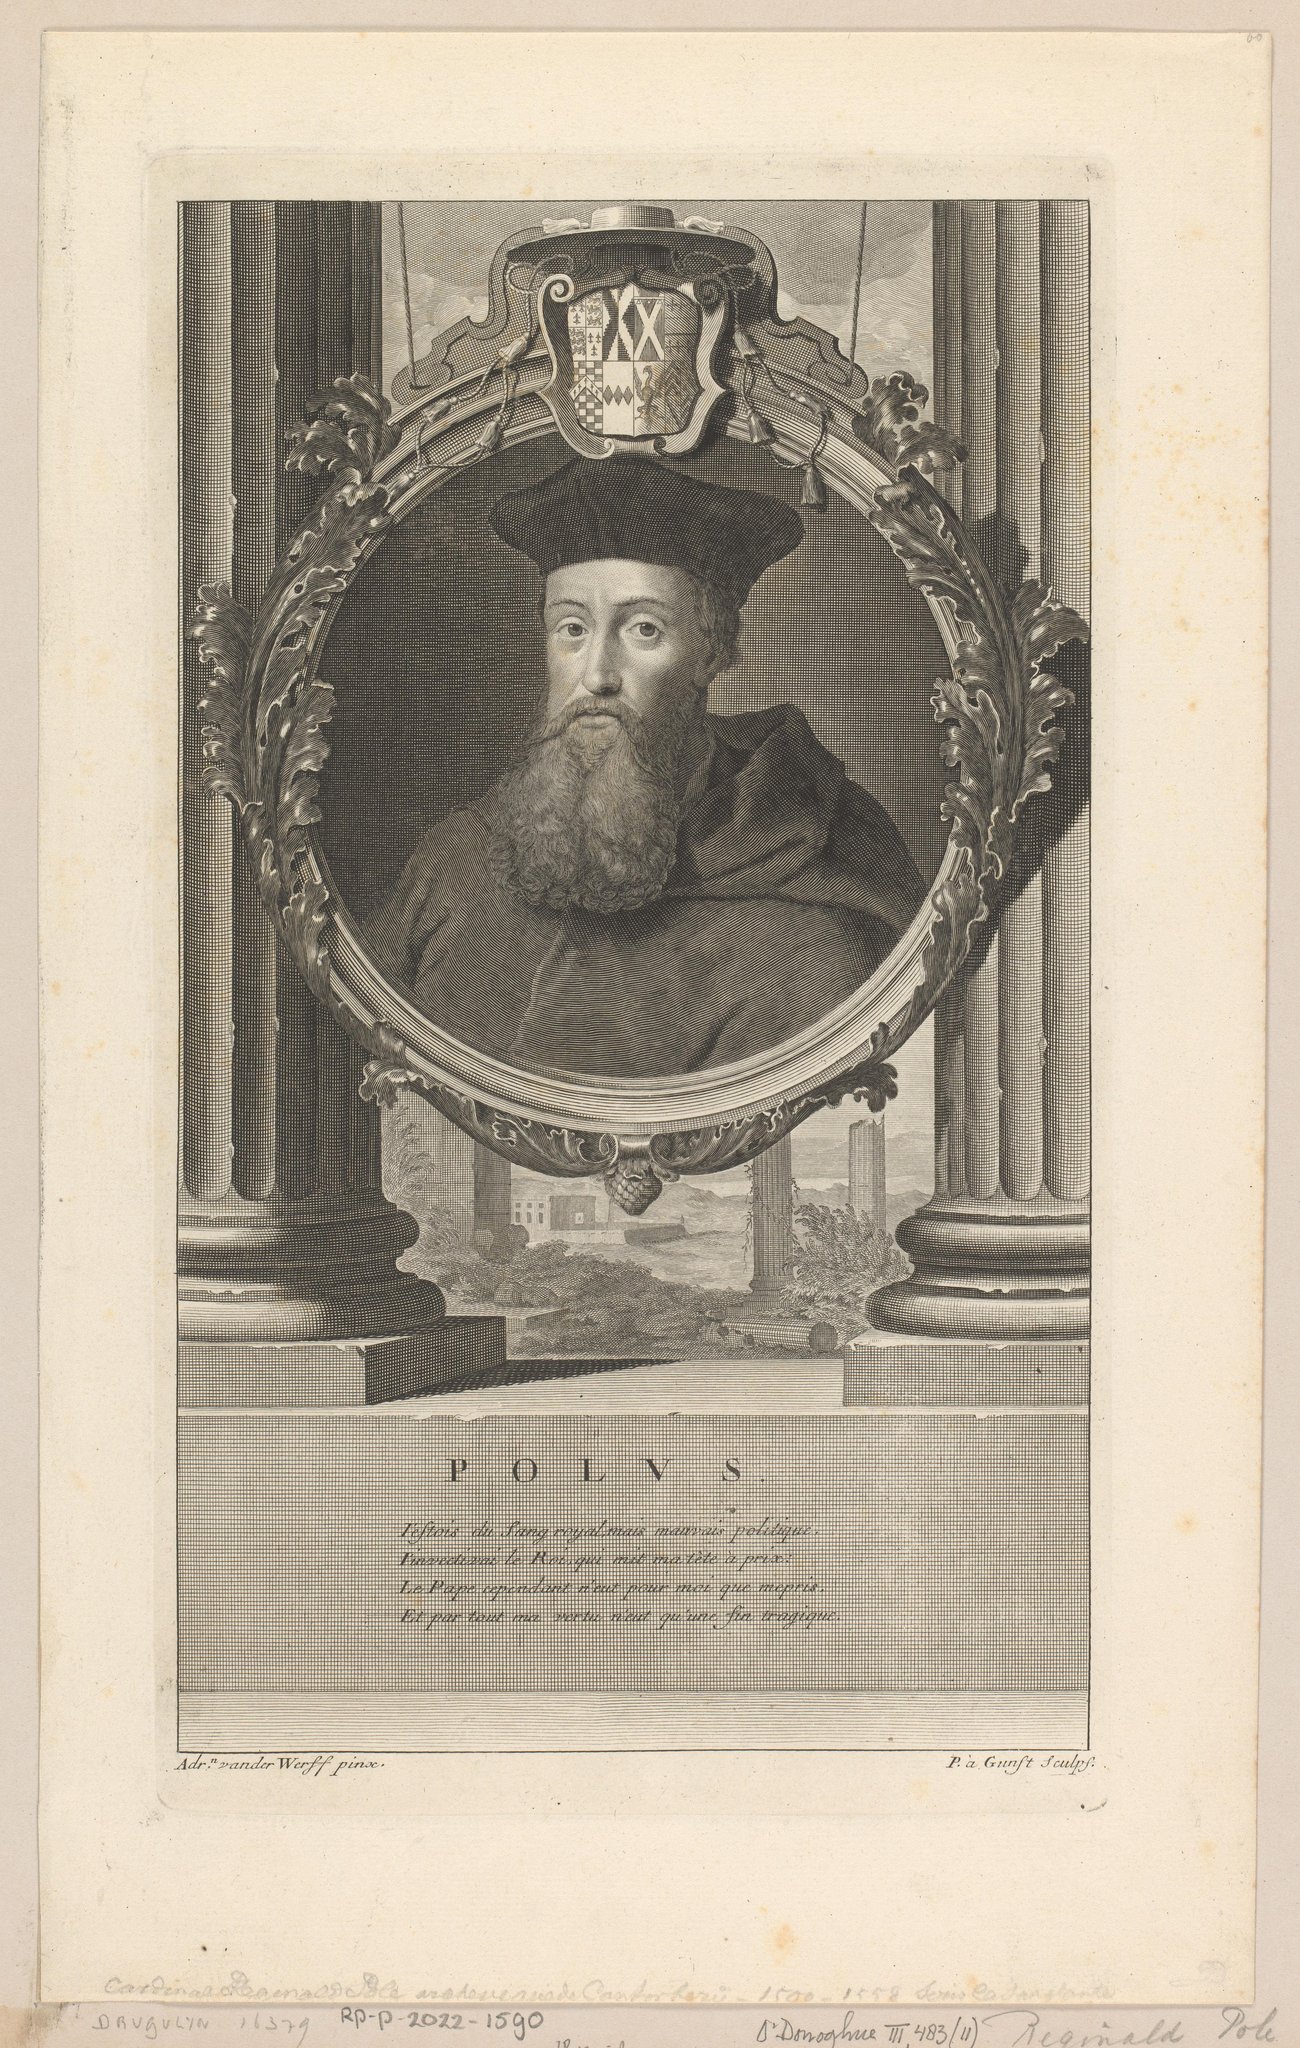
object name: print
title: Portret van Reginald Pole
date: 1669-1731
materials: paper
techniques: engraving, etching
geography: amsterdam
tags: london, cardinal, historical persons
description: Met vierregelig onderschrift in het Frans.